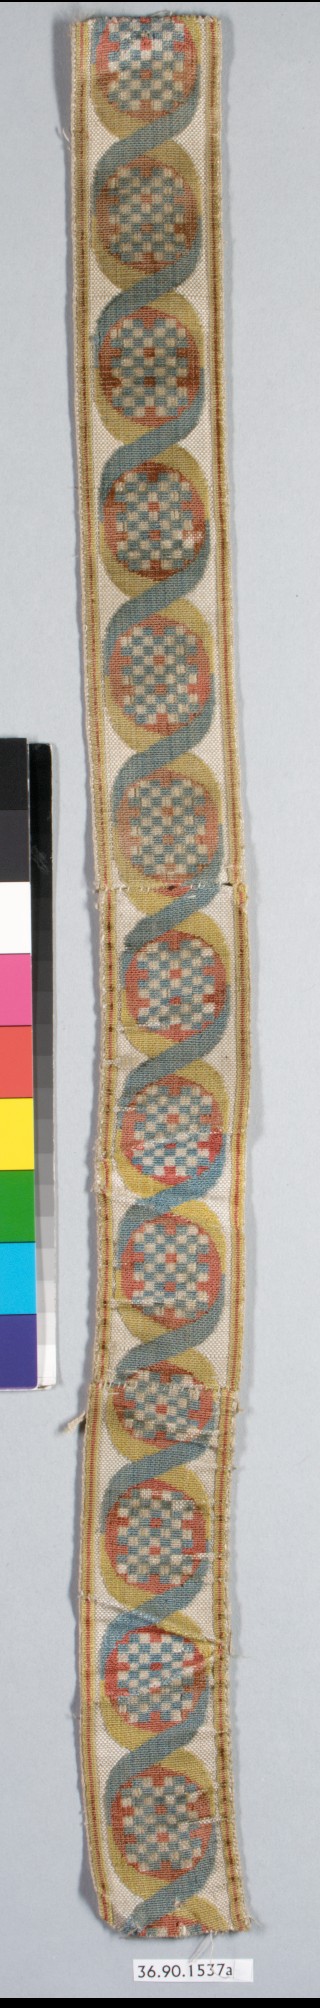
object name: galloon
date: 1701-1900